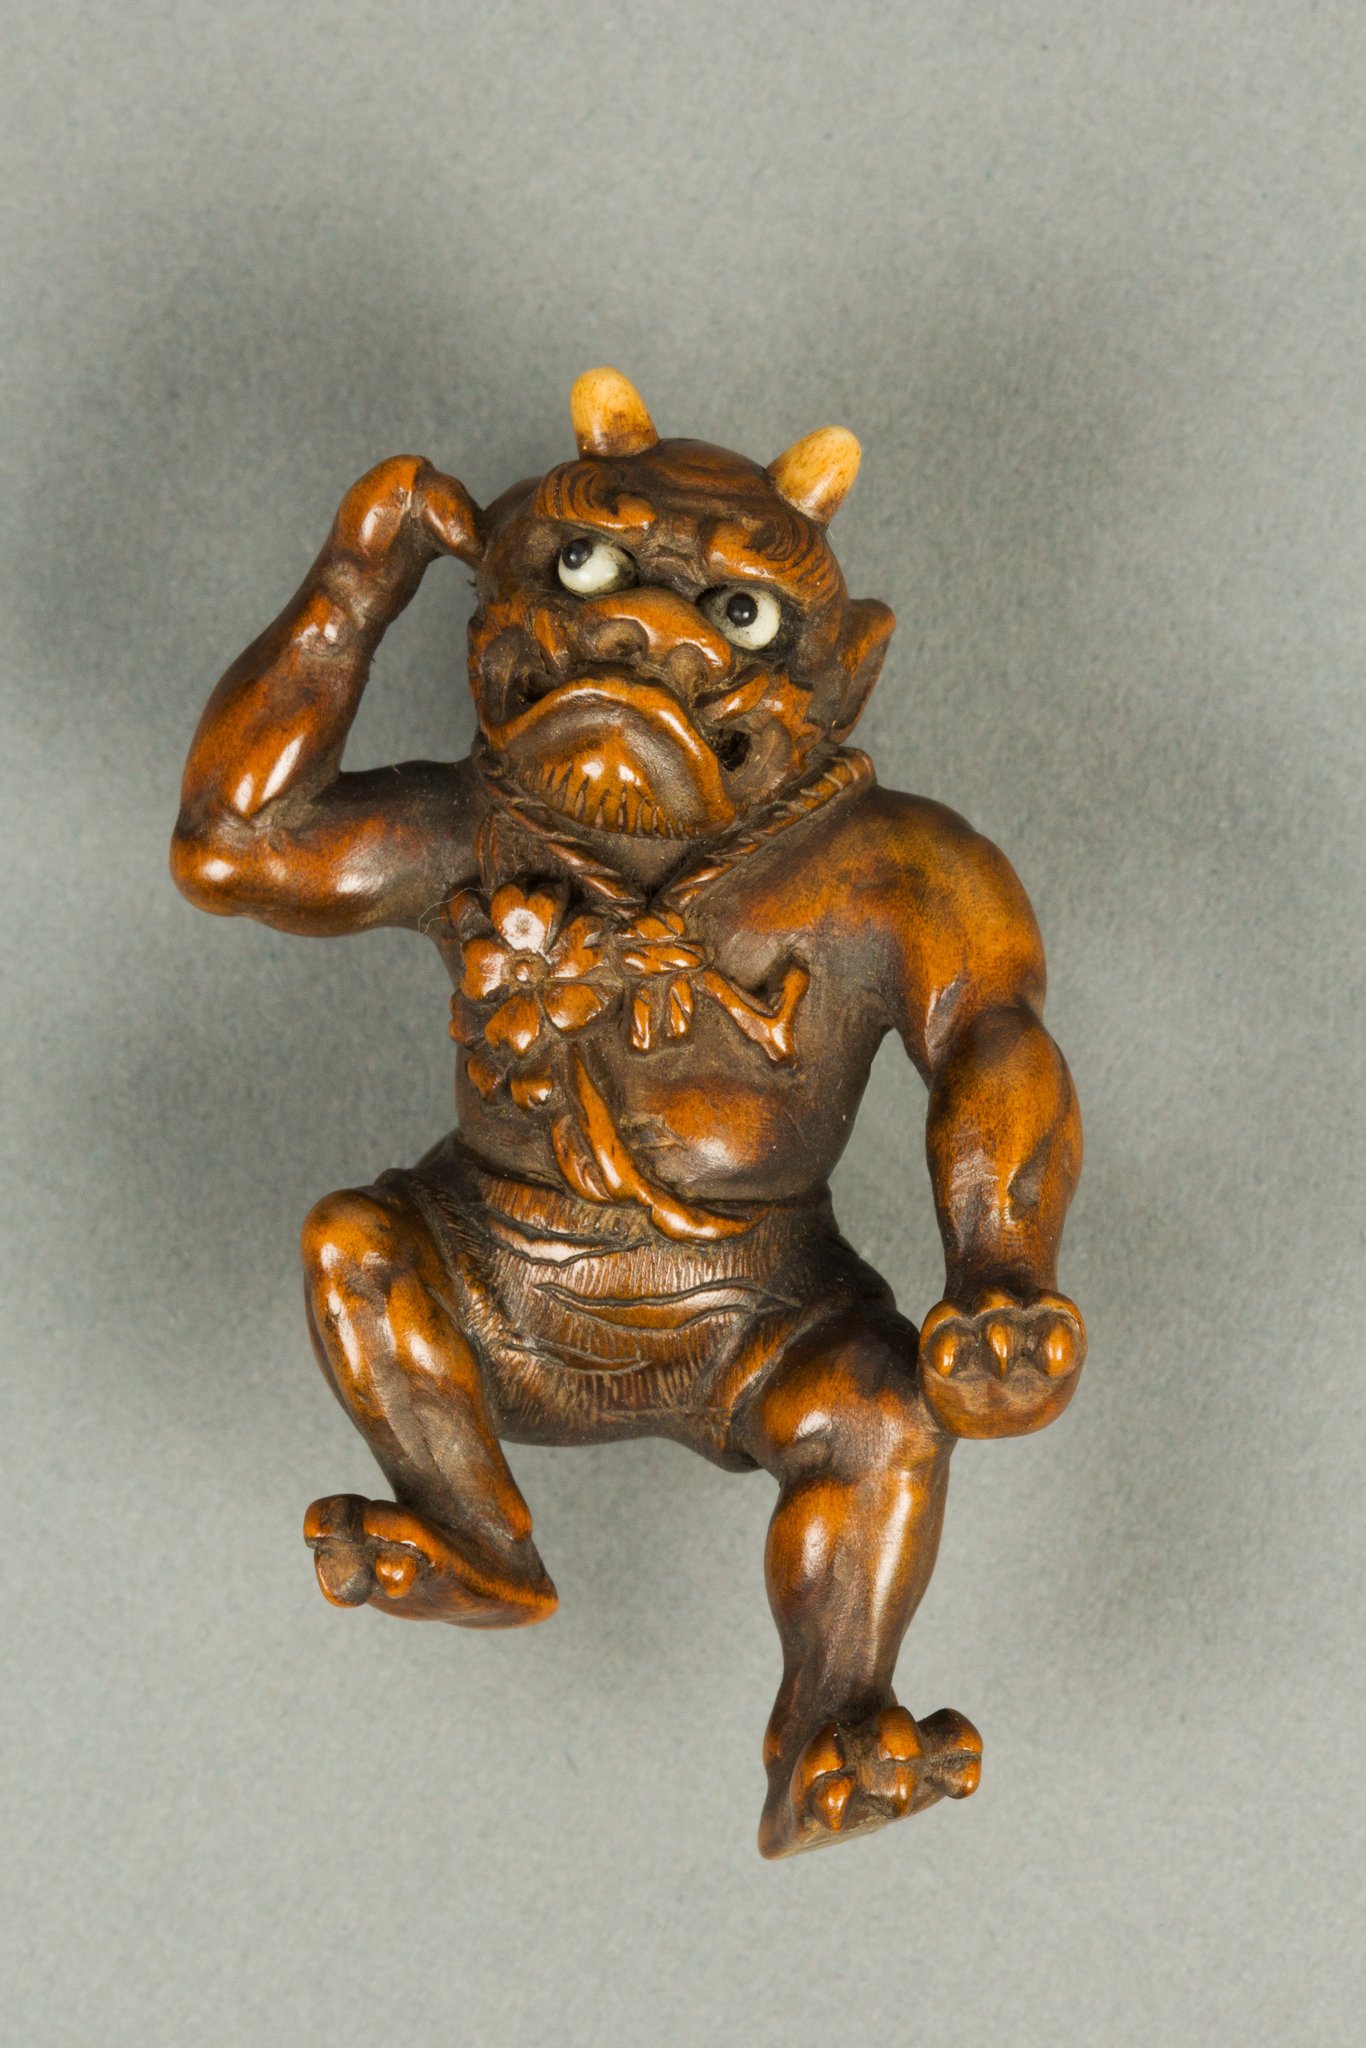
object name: netsuke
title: Netsuke of Demon Carrying a Gourd on His Back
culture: japanese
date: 1701-1800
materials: wood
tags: demons